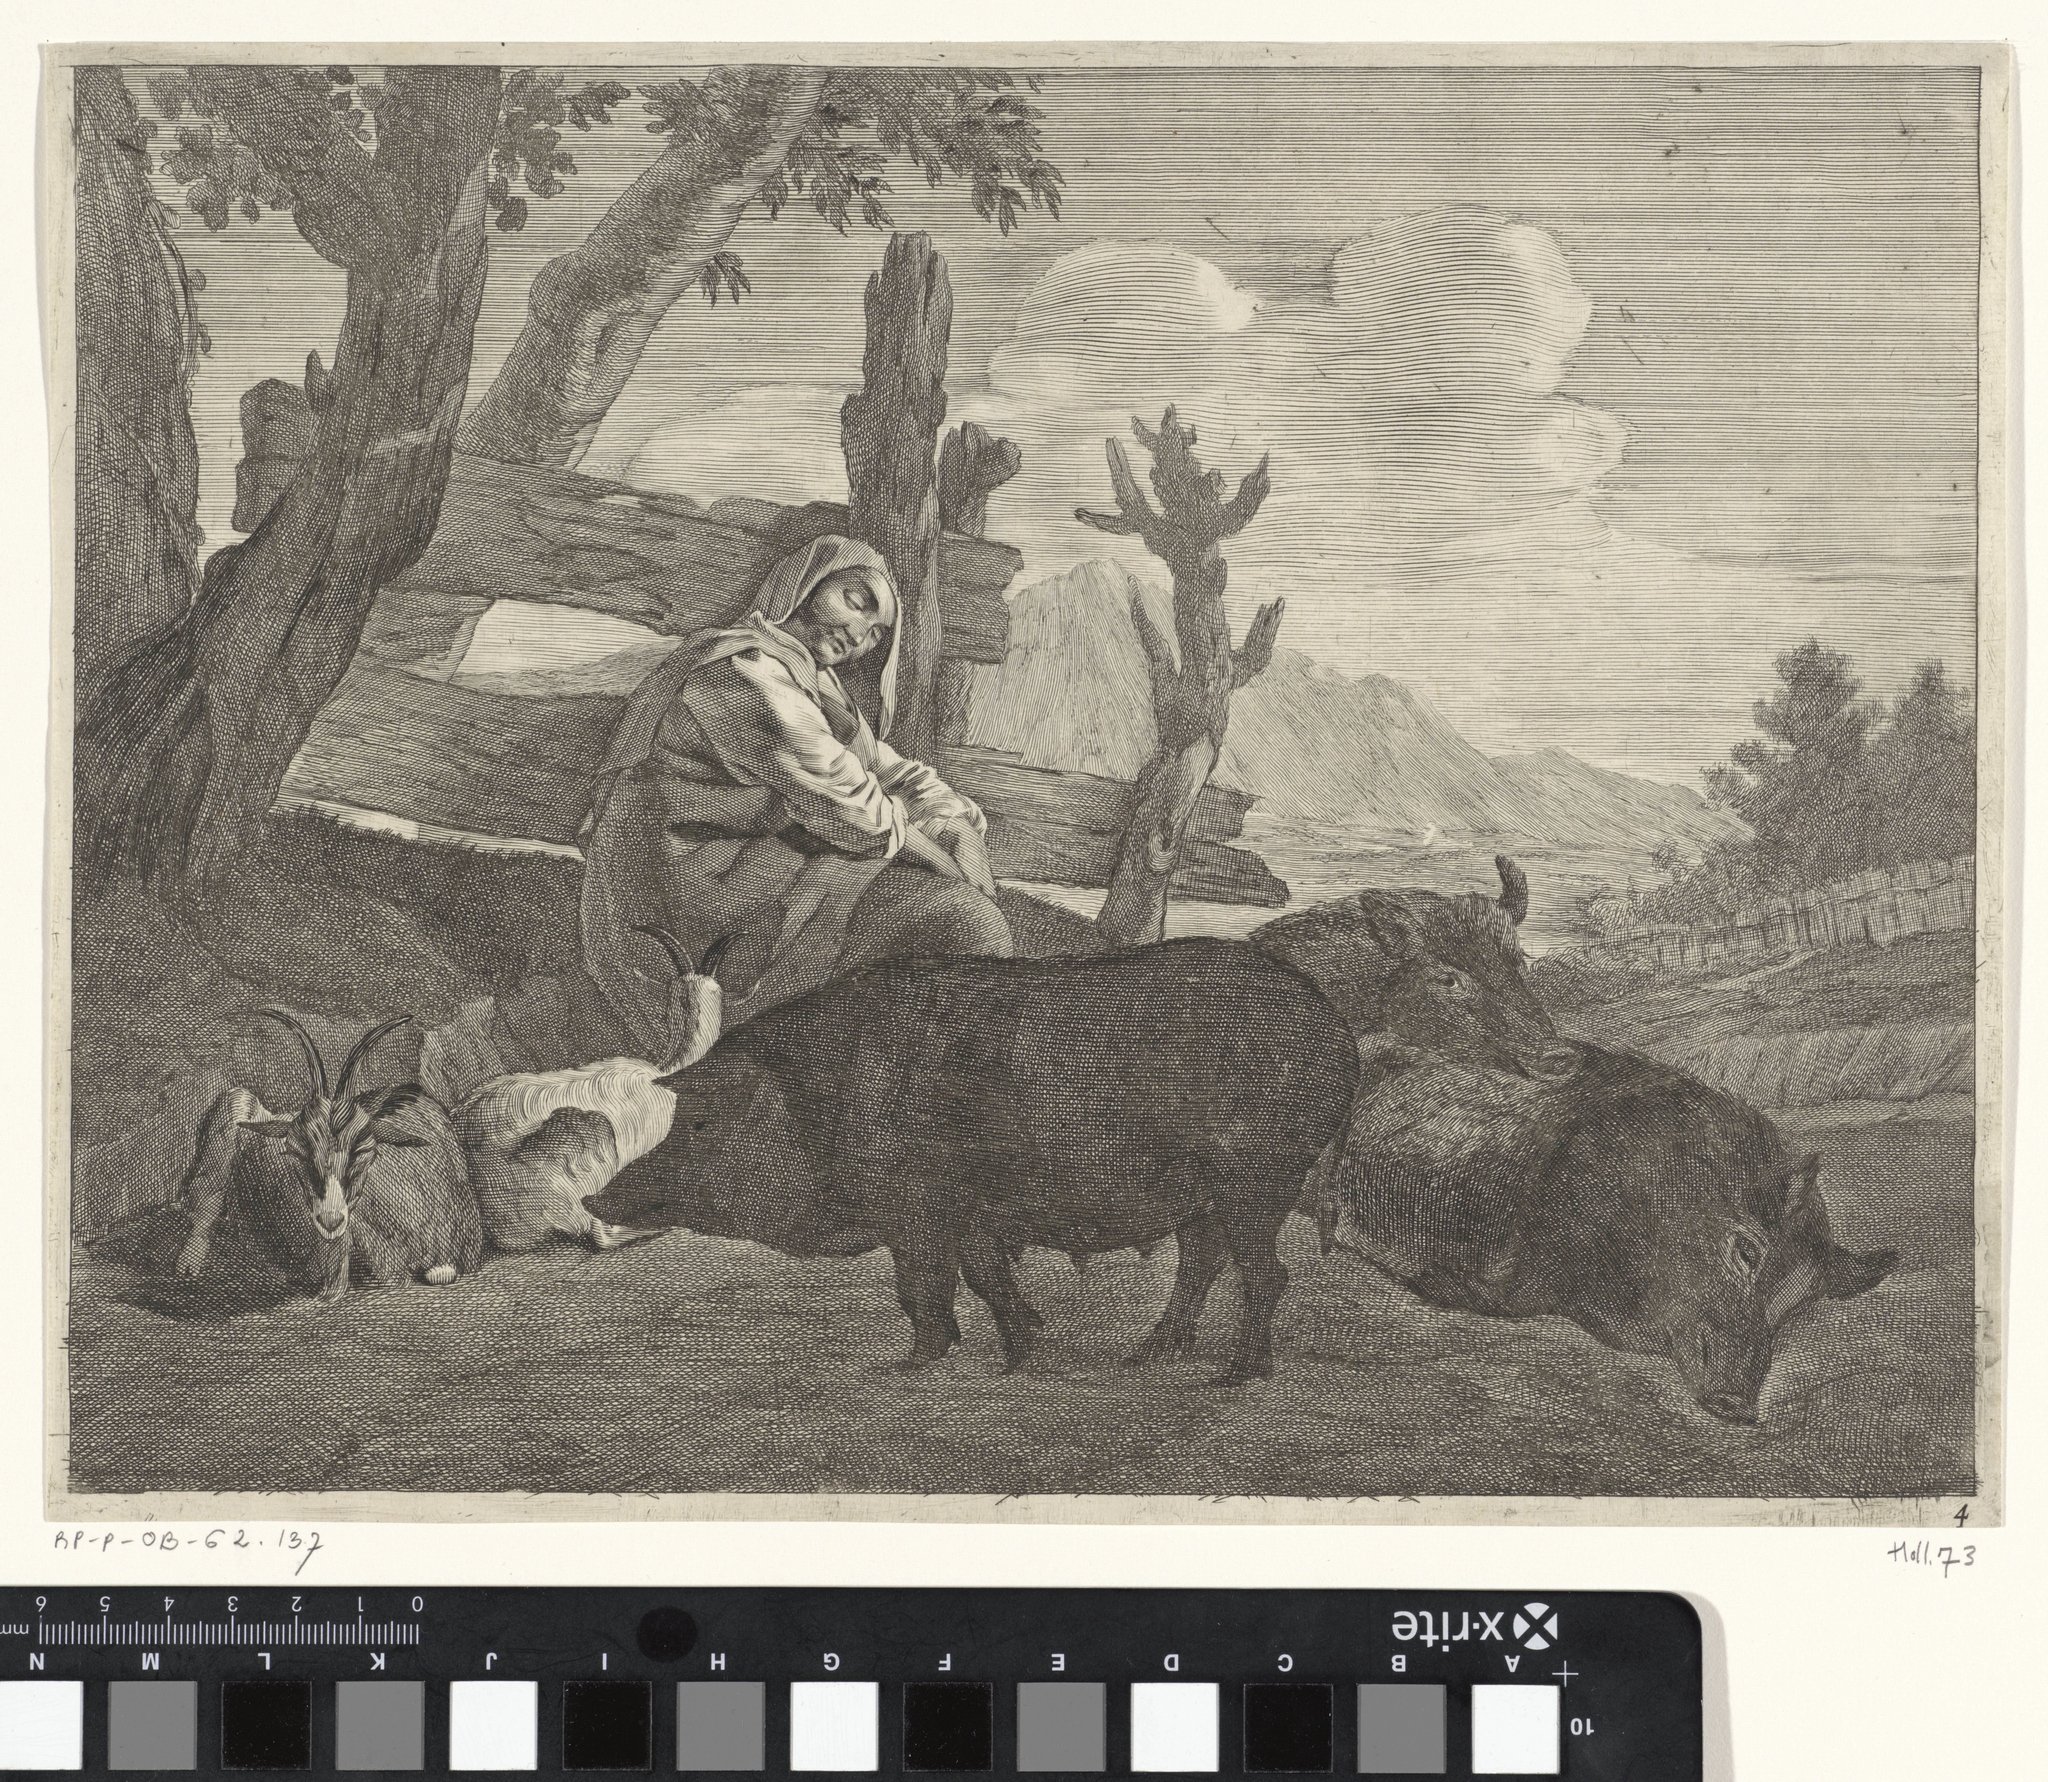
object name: print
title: Slapende herderin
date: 1638-1658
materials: paper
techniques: engraving, etching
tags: pig, landscapes, sleeping; unconsciousness, goat, mountains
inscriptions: collector's mark: Lugt 240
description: In een landschap ligt een herderin onder een boom tegen een hek aan te slapen. Naast haar liggen twee geitjes en voor haar drie zwijnen. Op de achtergrond zijn bergen te zien.